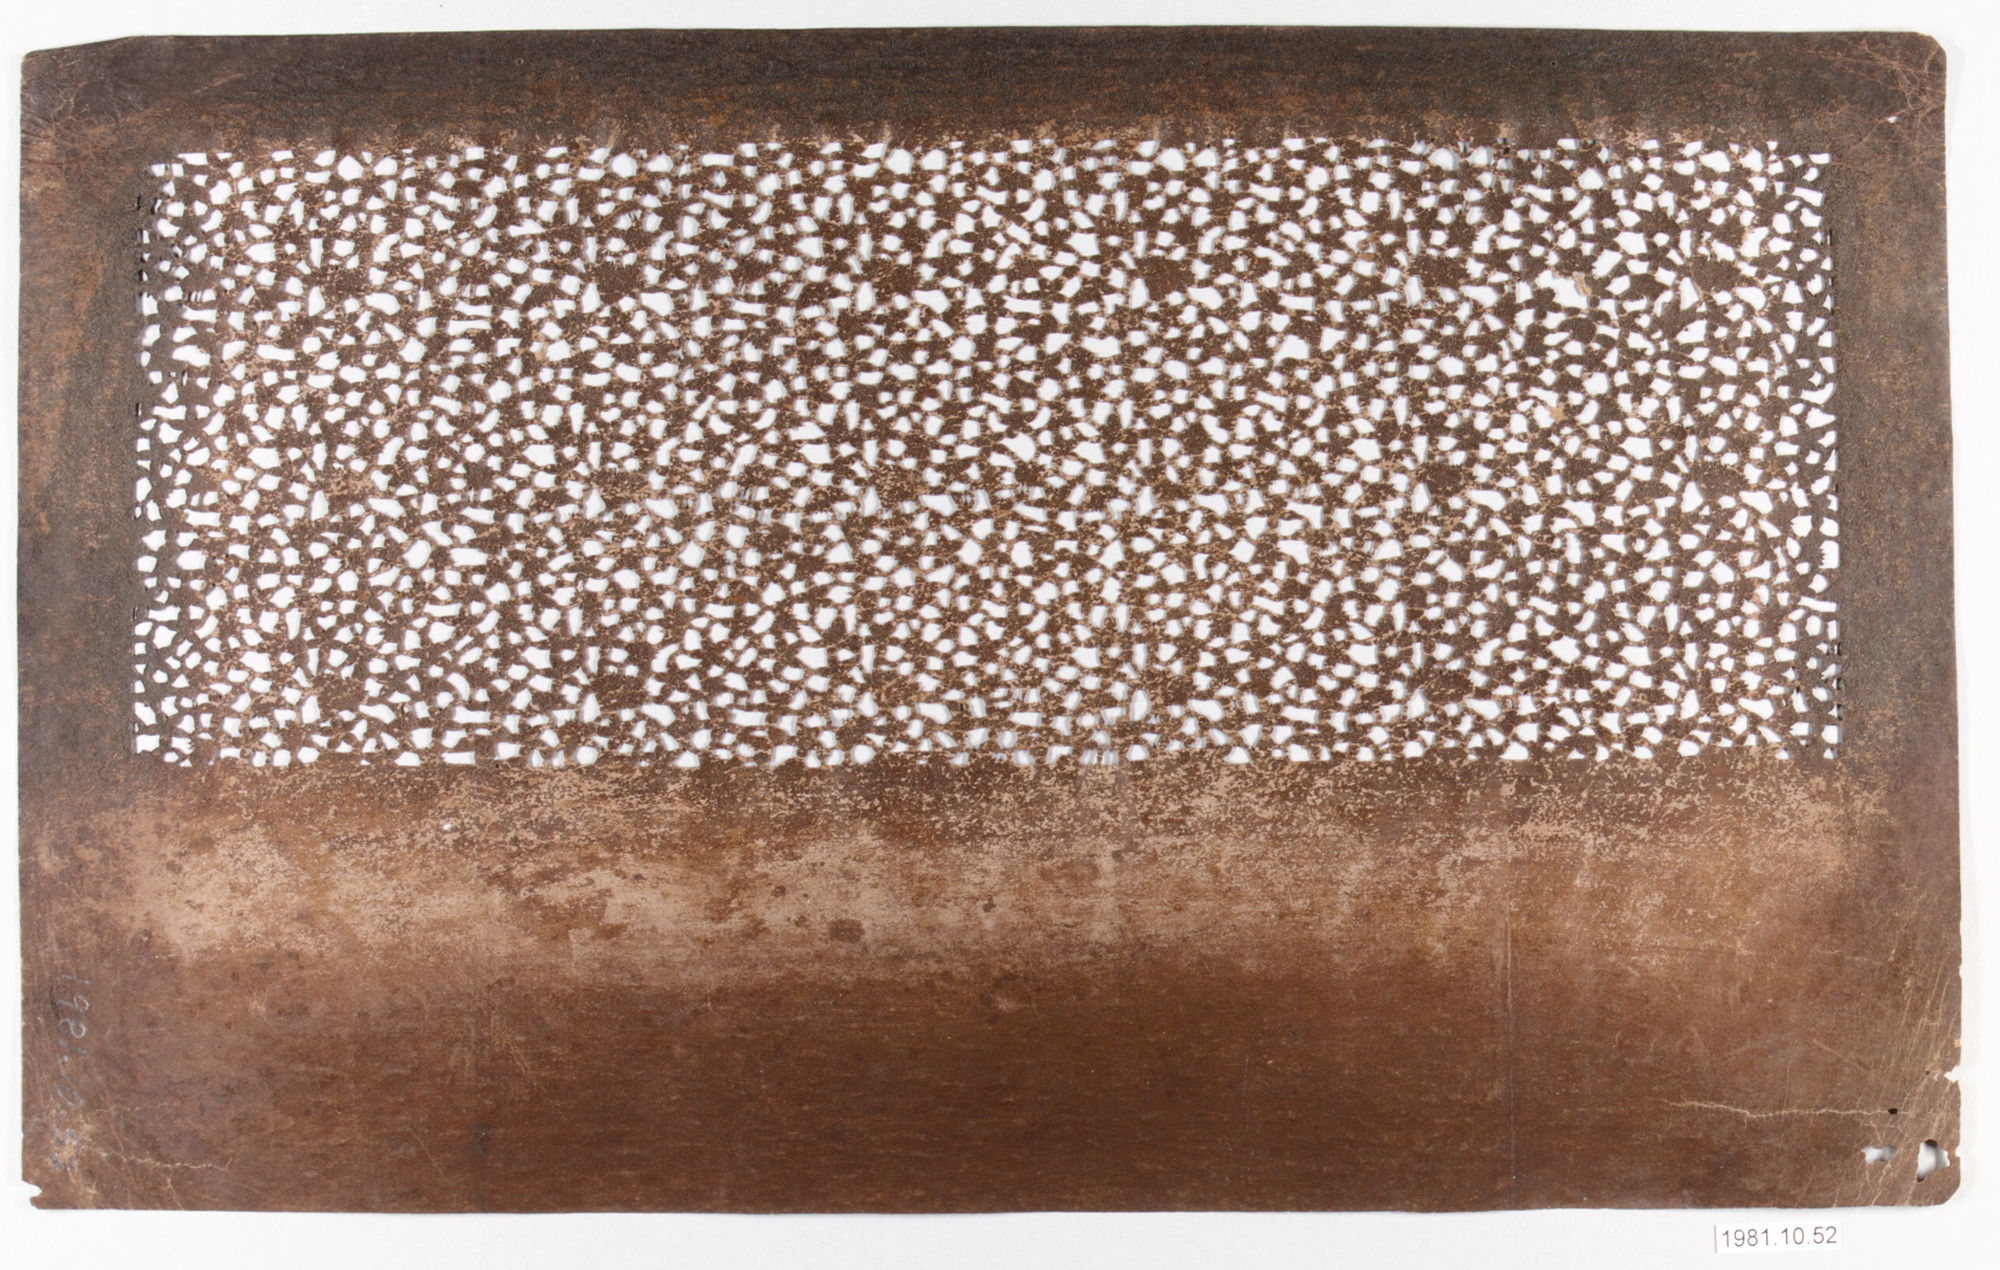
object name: stencil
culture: japanese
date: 1801-1900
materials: paper